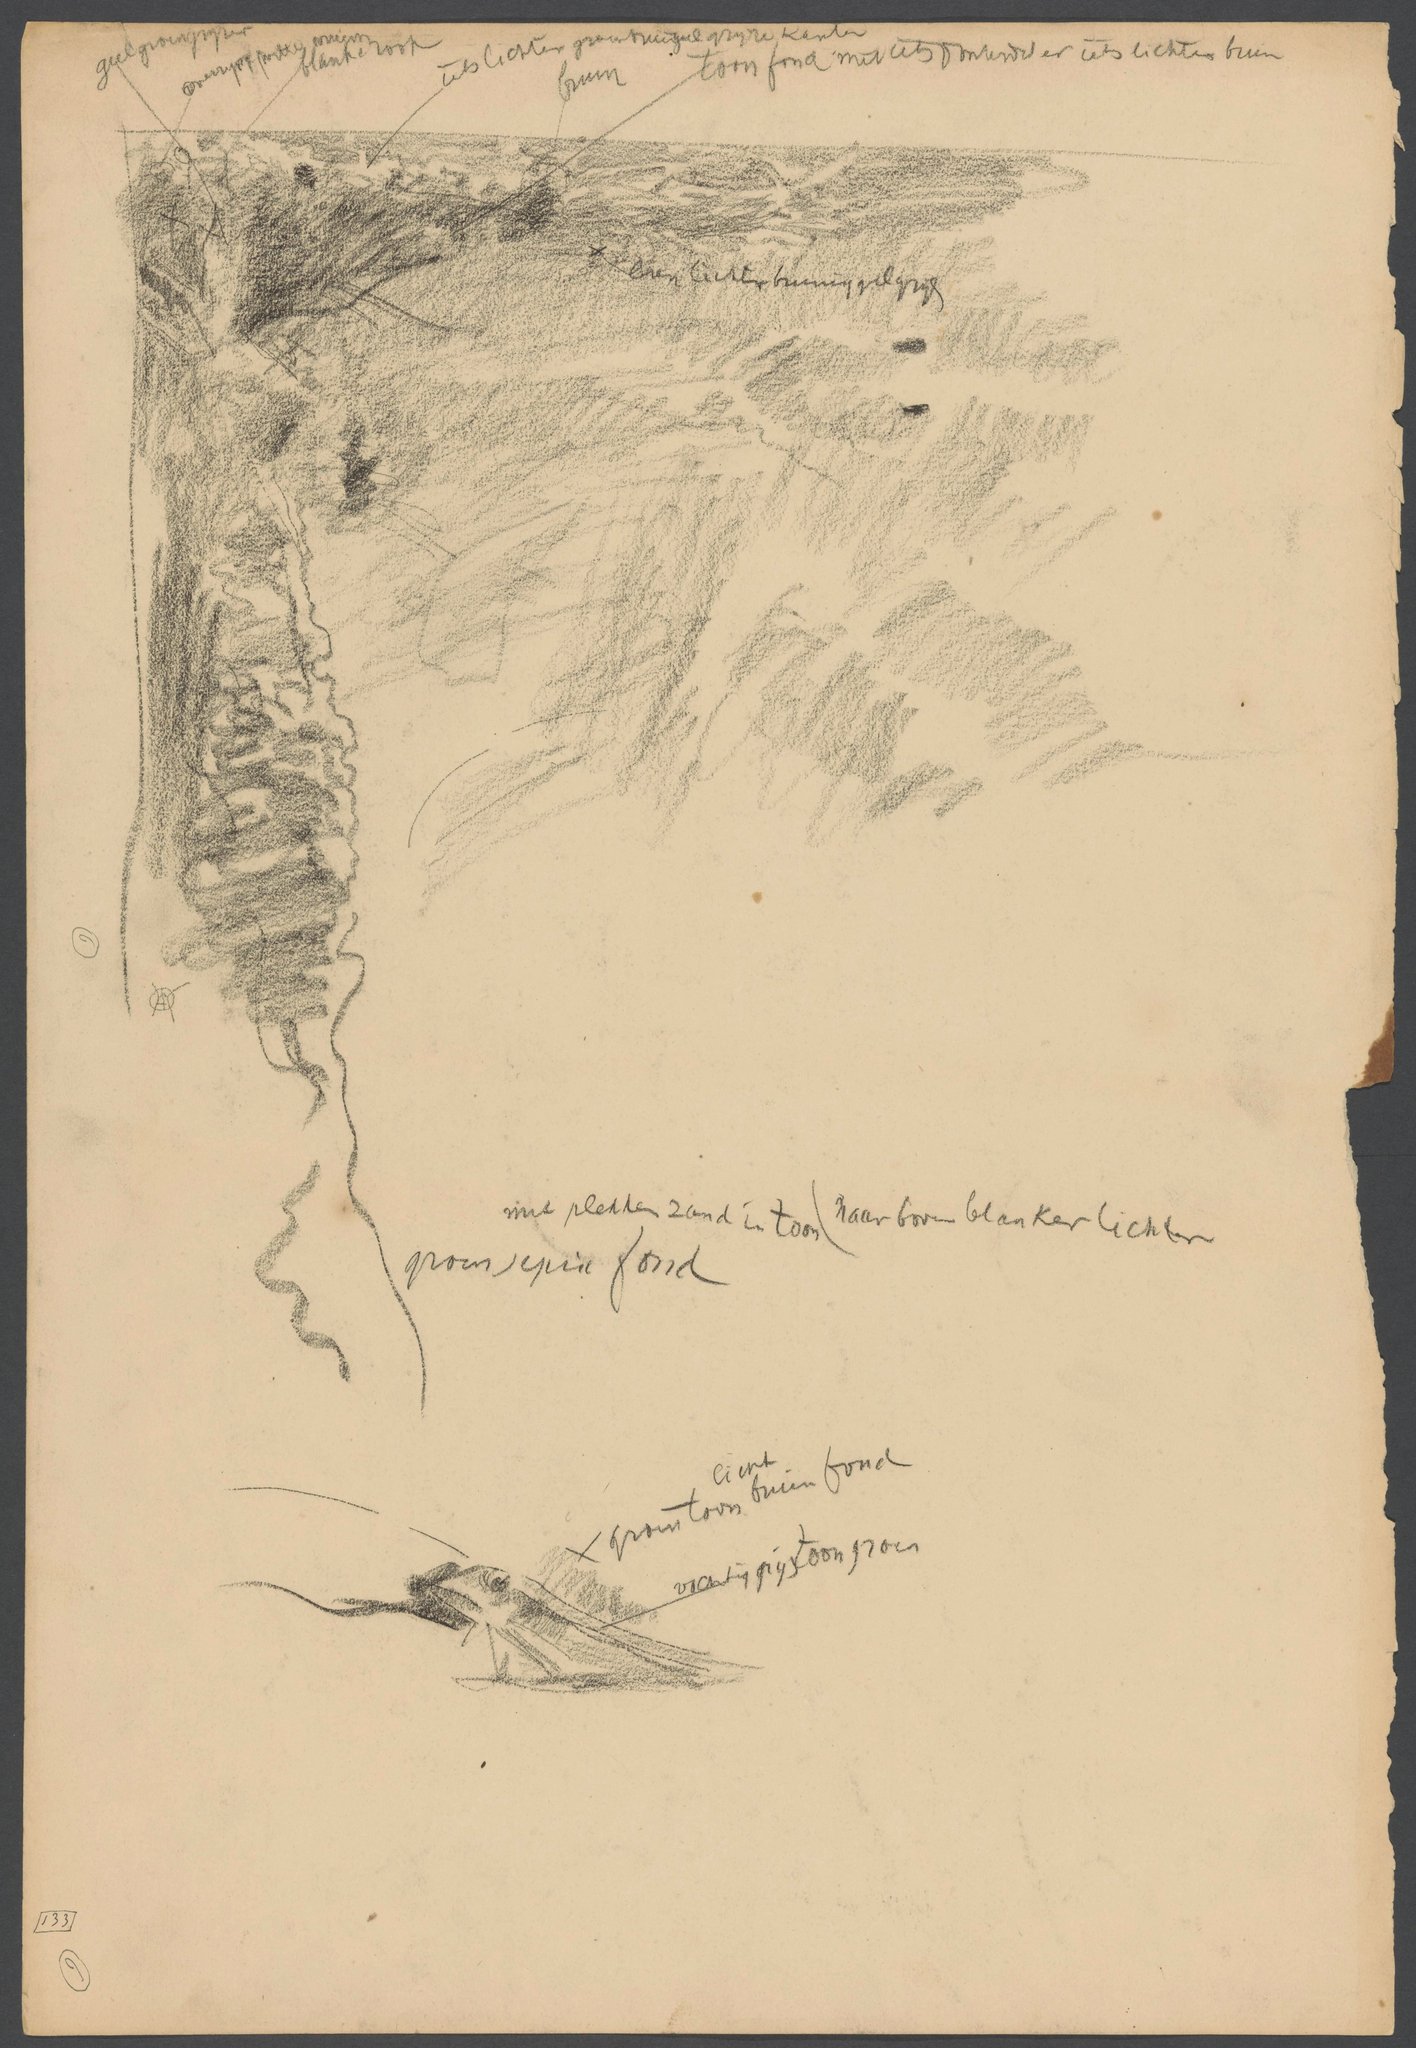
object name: drawing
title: Schets van een aquarium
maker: gerrit willem dijsselhof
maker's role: designer, draughtsman, print maker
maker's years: 1866-1924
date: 1876-1924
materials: chalk, paper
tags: aquarium